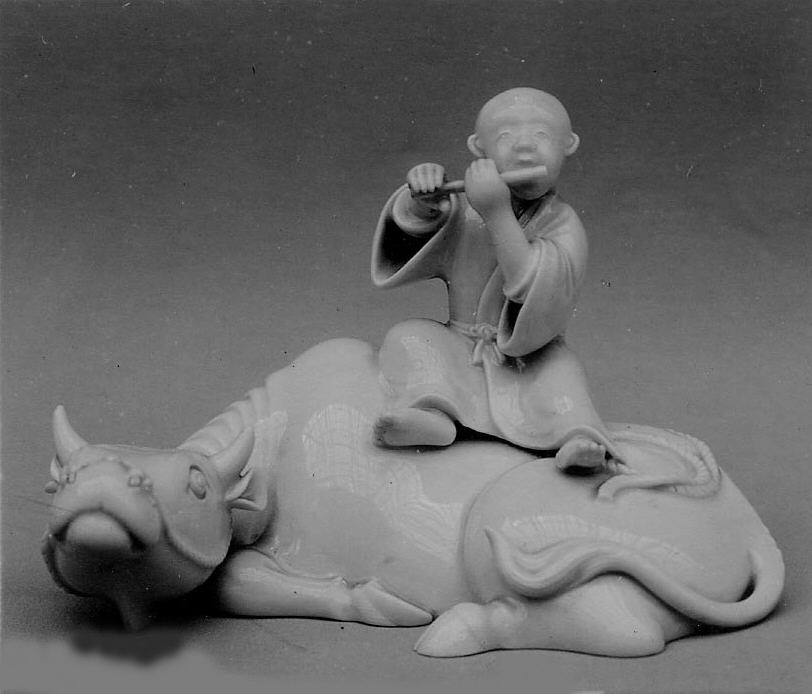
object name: figure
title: Boy Seated on an Ox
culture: japanese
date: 1801-1900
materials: porcelain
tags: boys,flutes,bulls